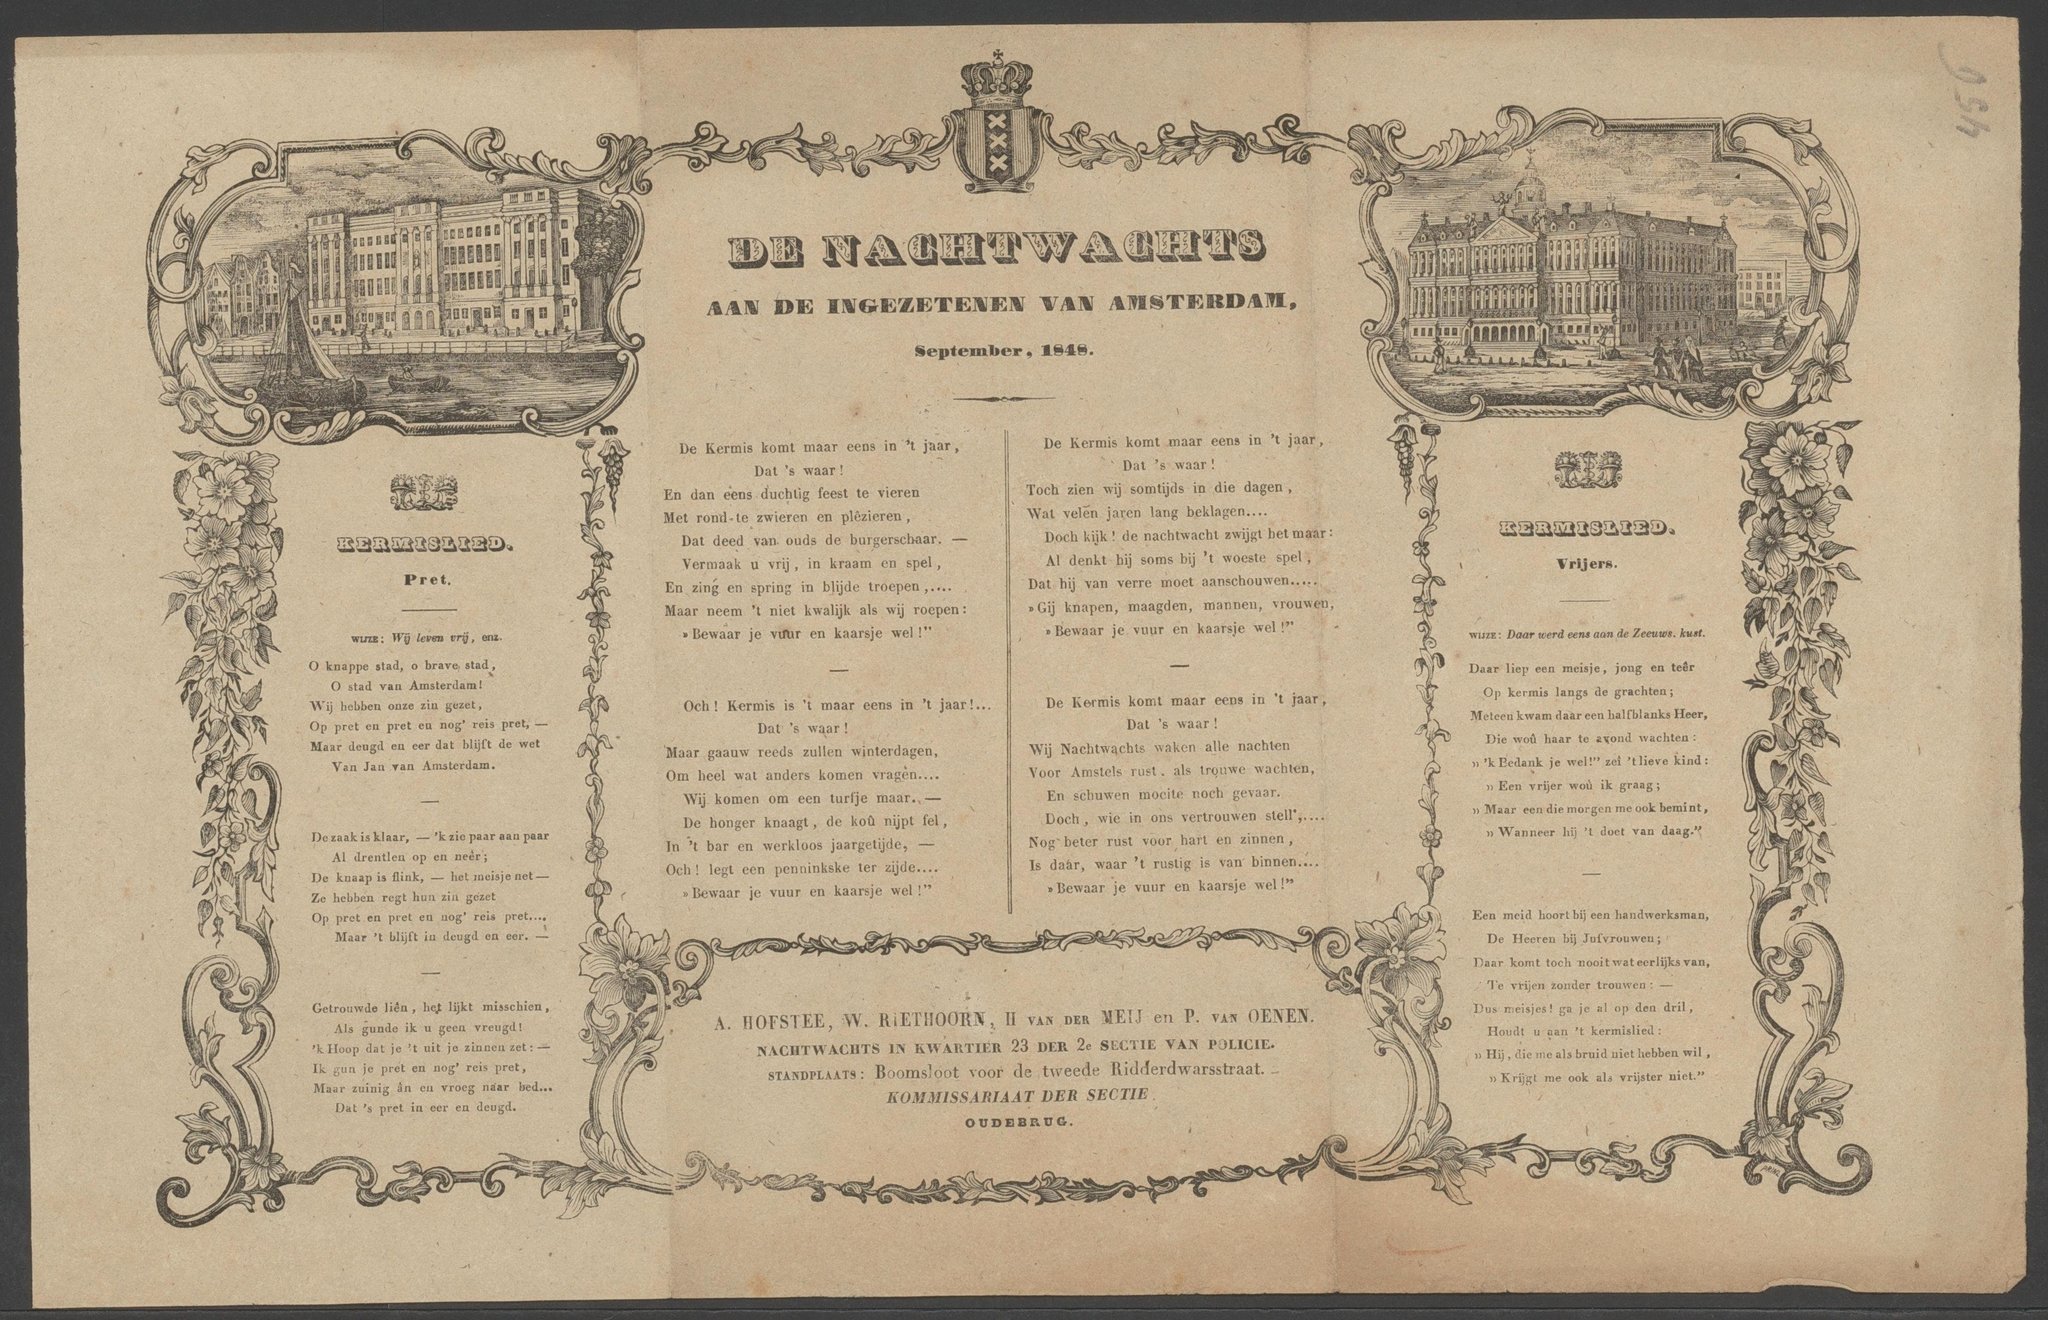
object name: print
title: Kermisprent van de Amsterdamse nachtwacht voor het jaar 1848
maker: Anonymous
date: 1848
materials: paper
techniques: letterpress printing, engraving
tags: night patrol, palace, amsterdam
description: Kermisprent van de Amsterdamse nachtwacht, september 1848. Centraal een gedicht en aan beide zijde een kermislied. Door de ratelwachters: A. Hofstee, W. Riethoorn, H. van der Meij en P. van Oenen. Onderwerpsrubrieken binnen de Atlas Zeden en Gewoonten: Zeden en gewoonten in engeren zin, Volksleven, Volksbladen, Nieuwjaars- en Kerstwenschen, Amsterdam.